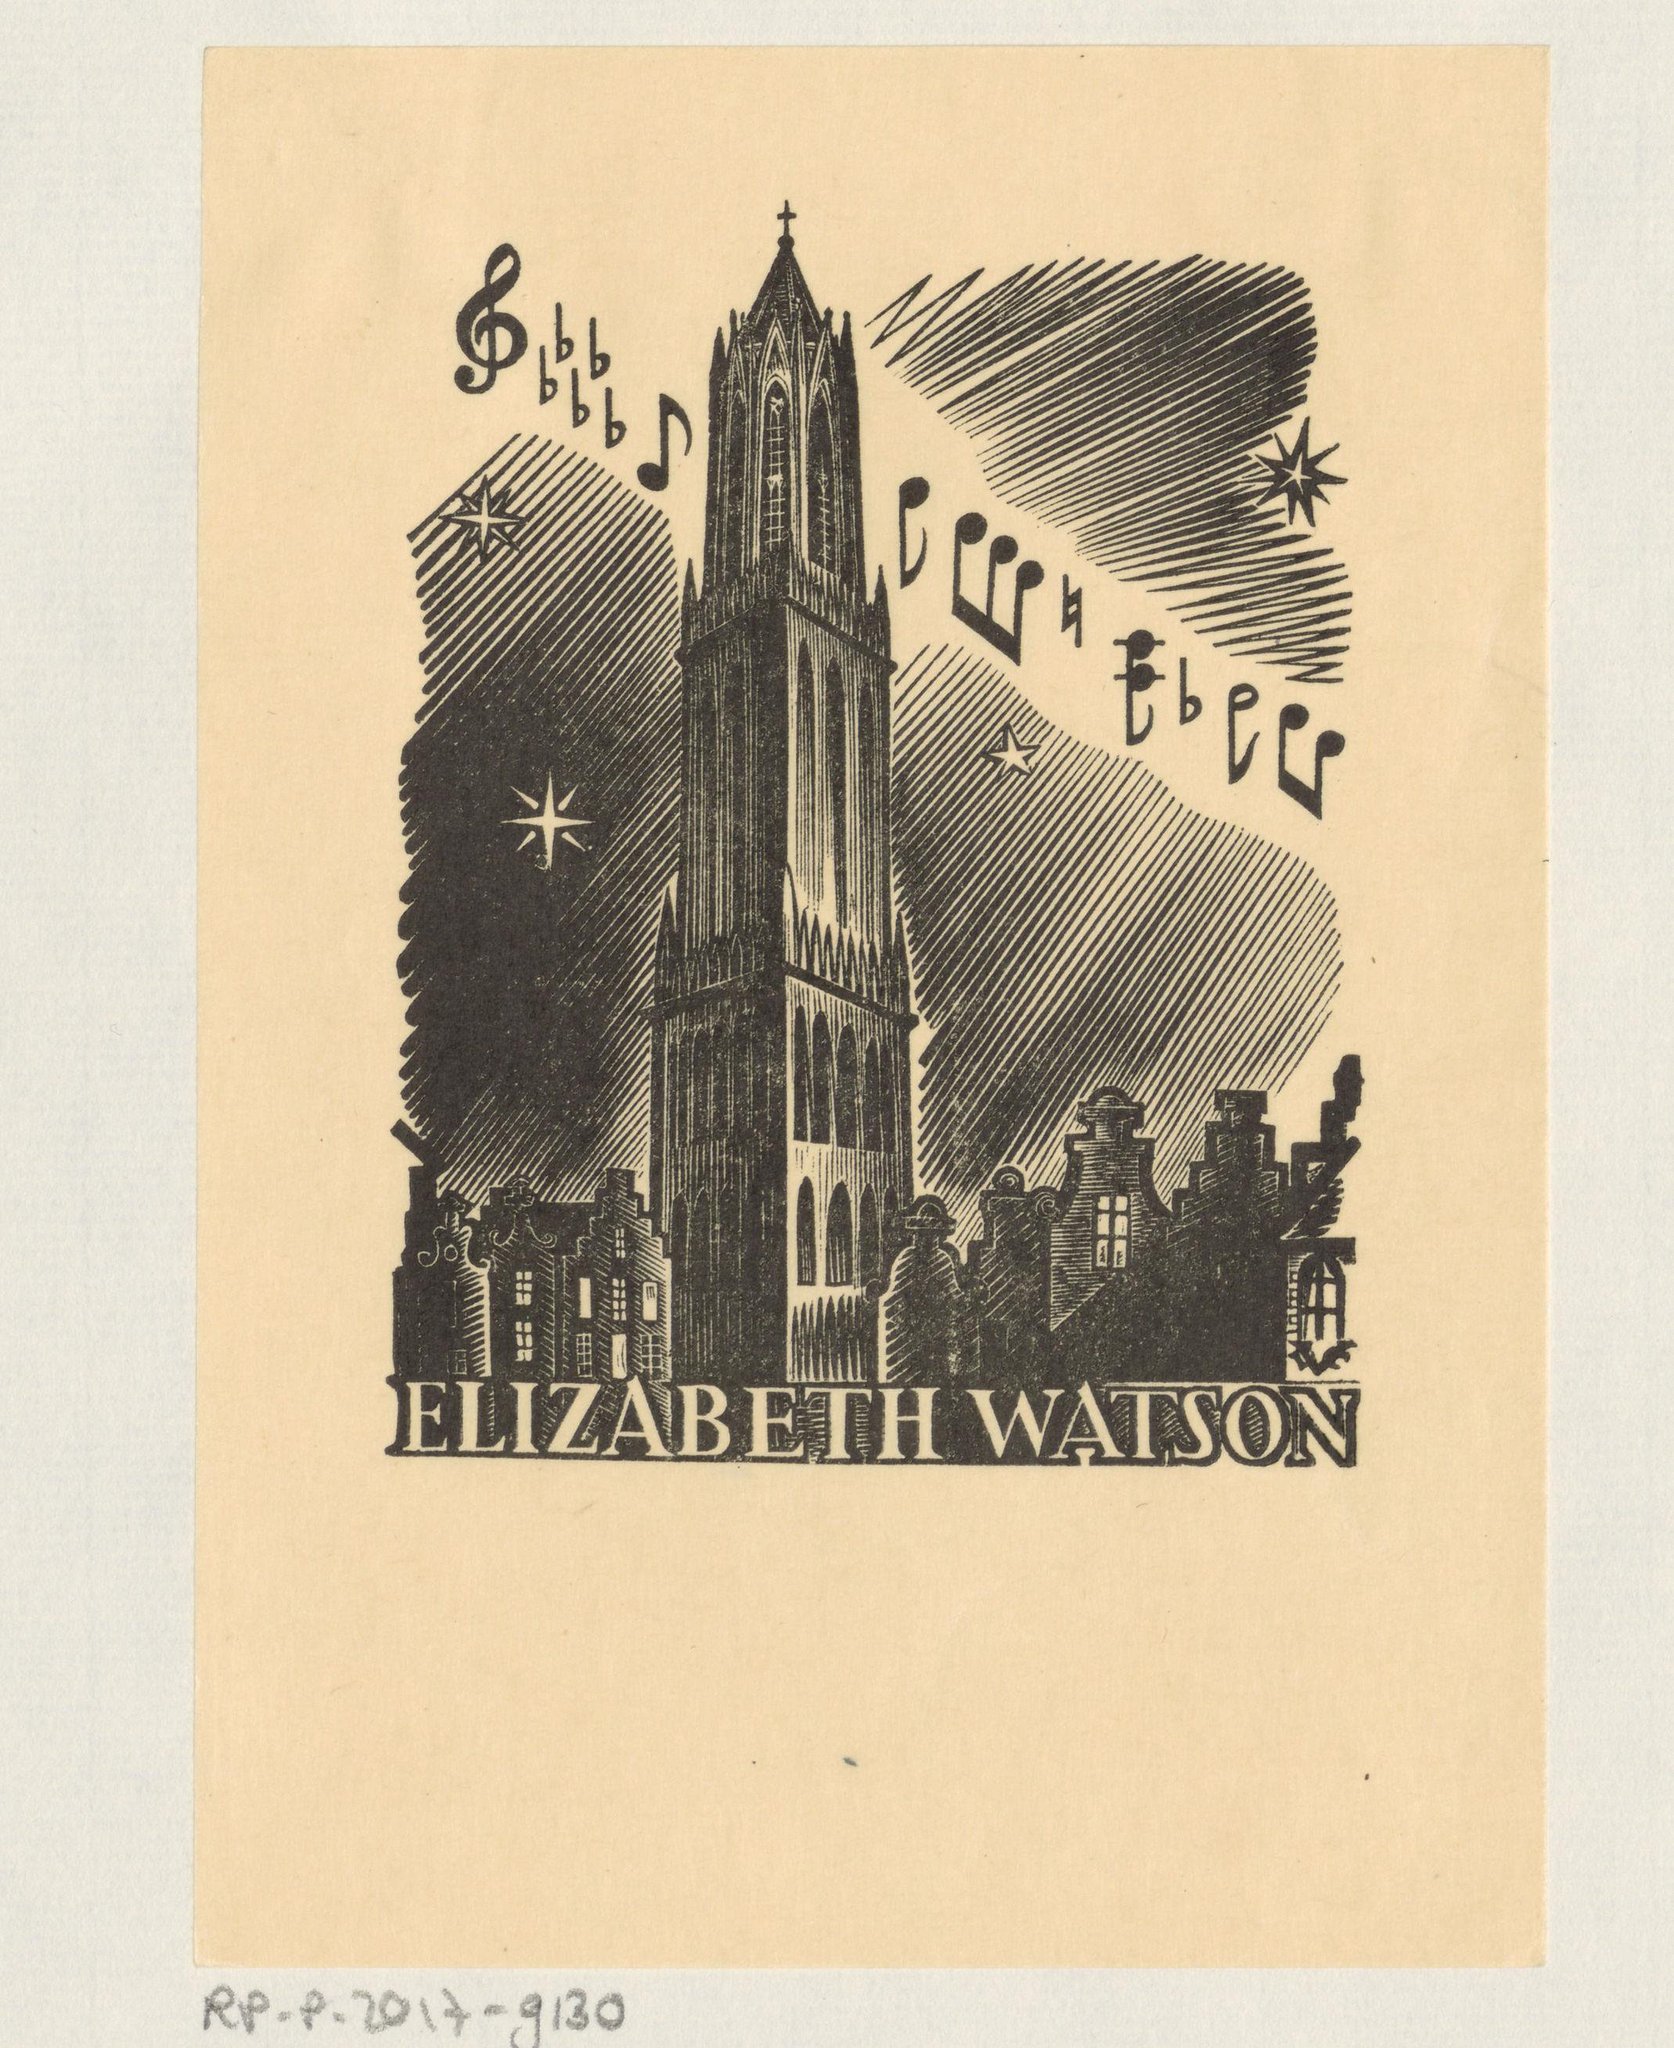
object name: bookplate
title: Ex libris van Elizabeth Watson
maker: valentin le campion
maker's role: print maker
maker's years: 1861-1952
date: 1920-1952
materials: paper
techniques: woodcut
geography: france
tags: parts of church exterior and annexes: campanile, prospect of city, town panorama, silhouette of city